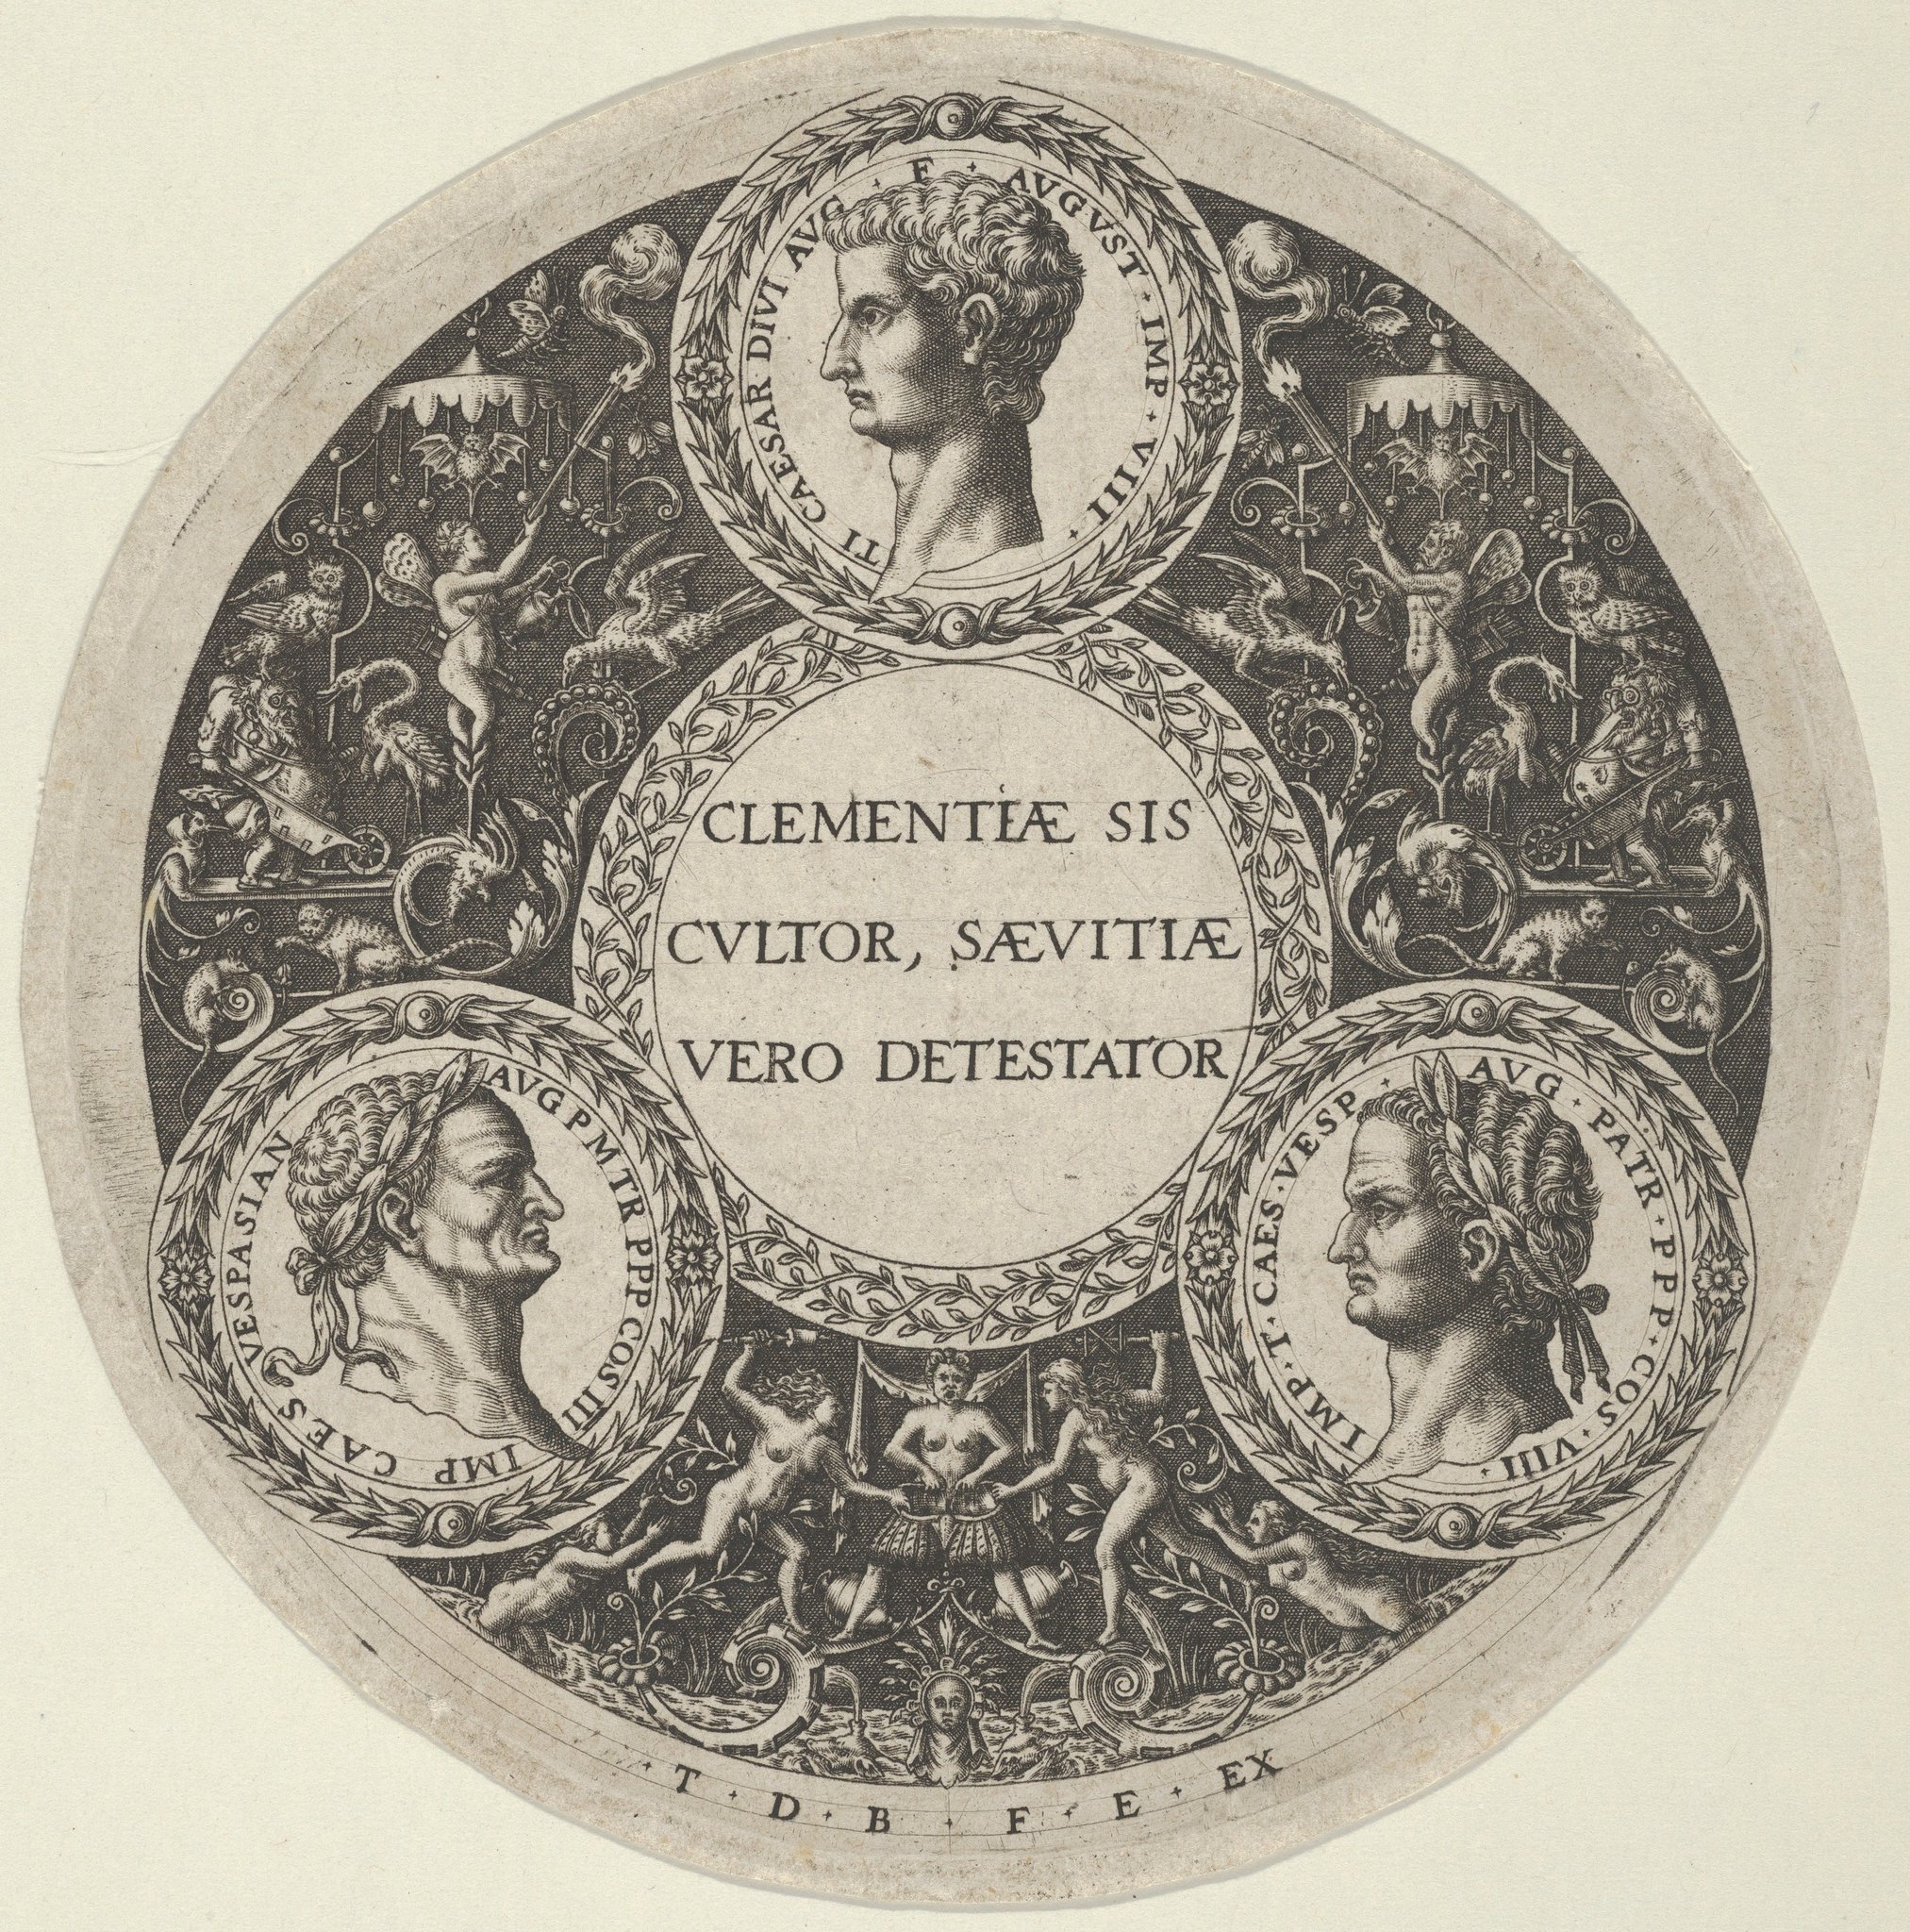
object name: print ornament architecture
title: Design for a Dish with Portraits of the Roman Emperors Tiberius, Vespasian, and Titus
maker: theodor de bry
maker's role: artist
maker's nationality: netherlandish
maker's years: 1528-1598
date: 1588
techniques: engraving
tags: birds,men,female nudes